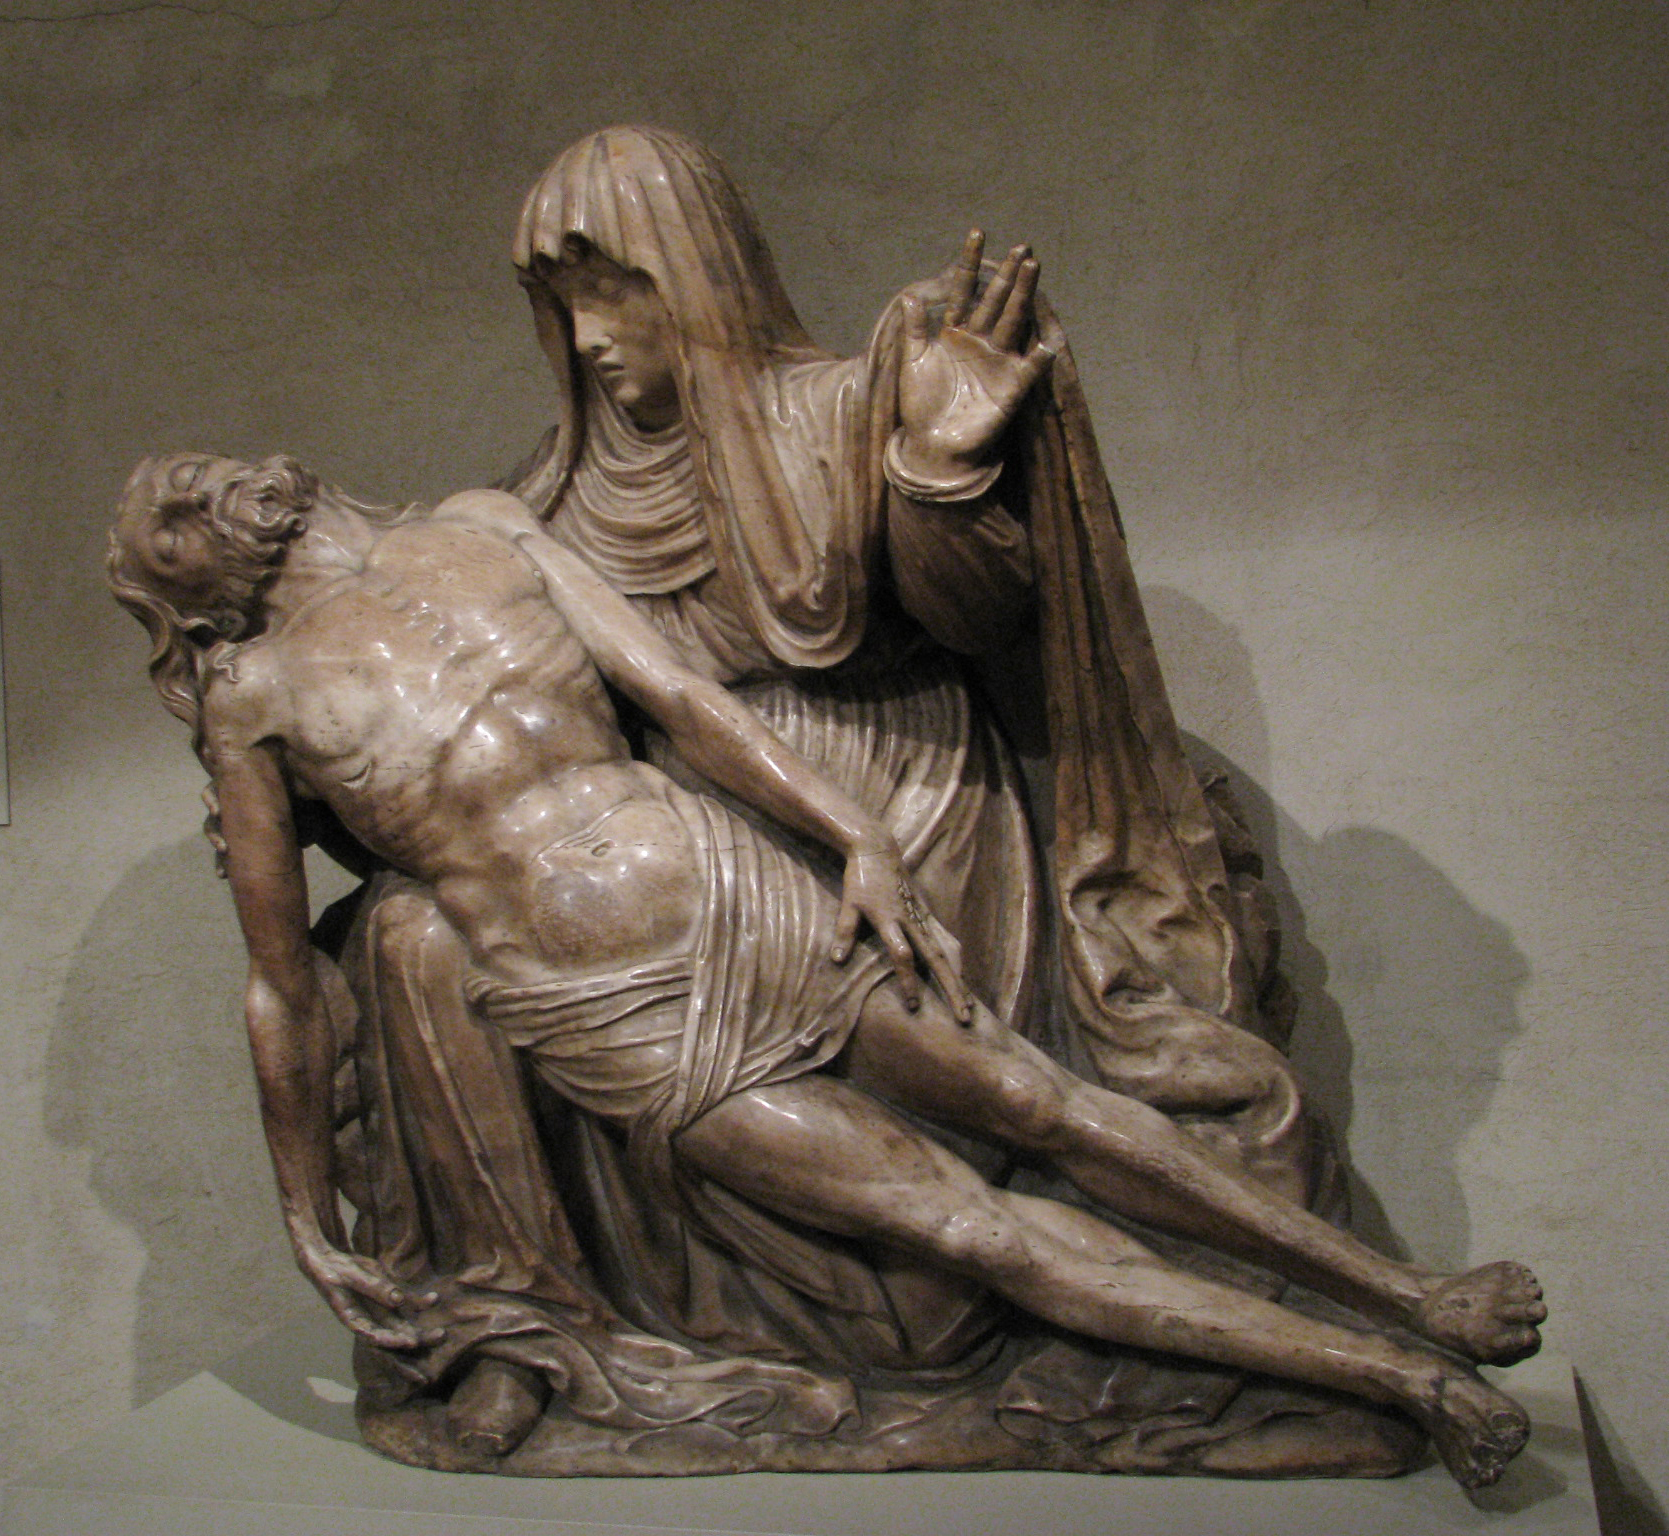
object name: group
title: Pietà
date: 1526-1550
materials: alabaster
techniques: polychromy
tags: sadness,christ,virgin mary